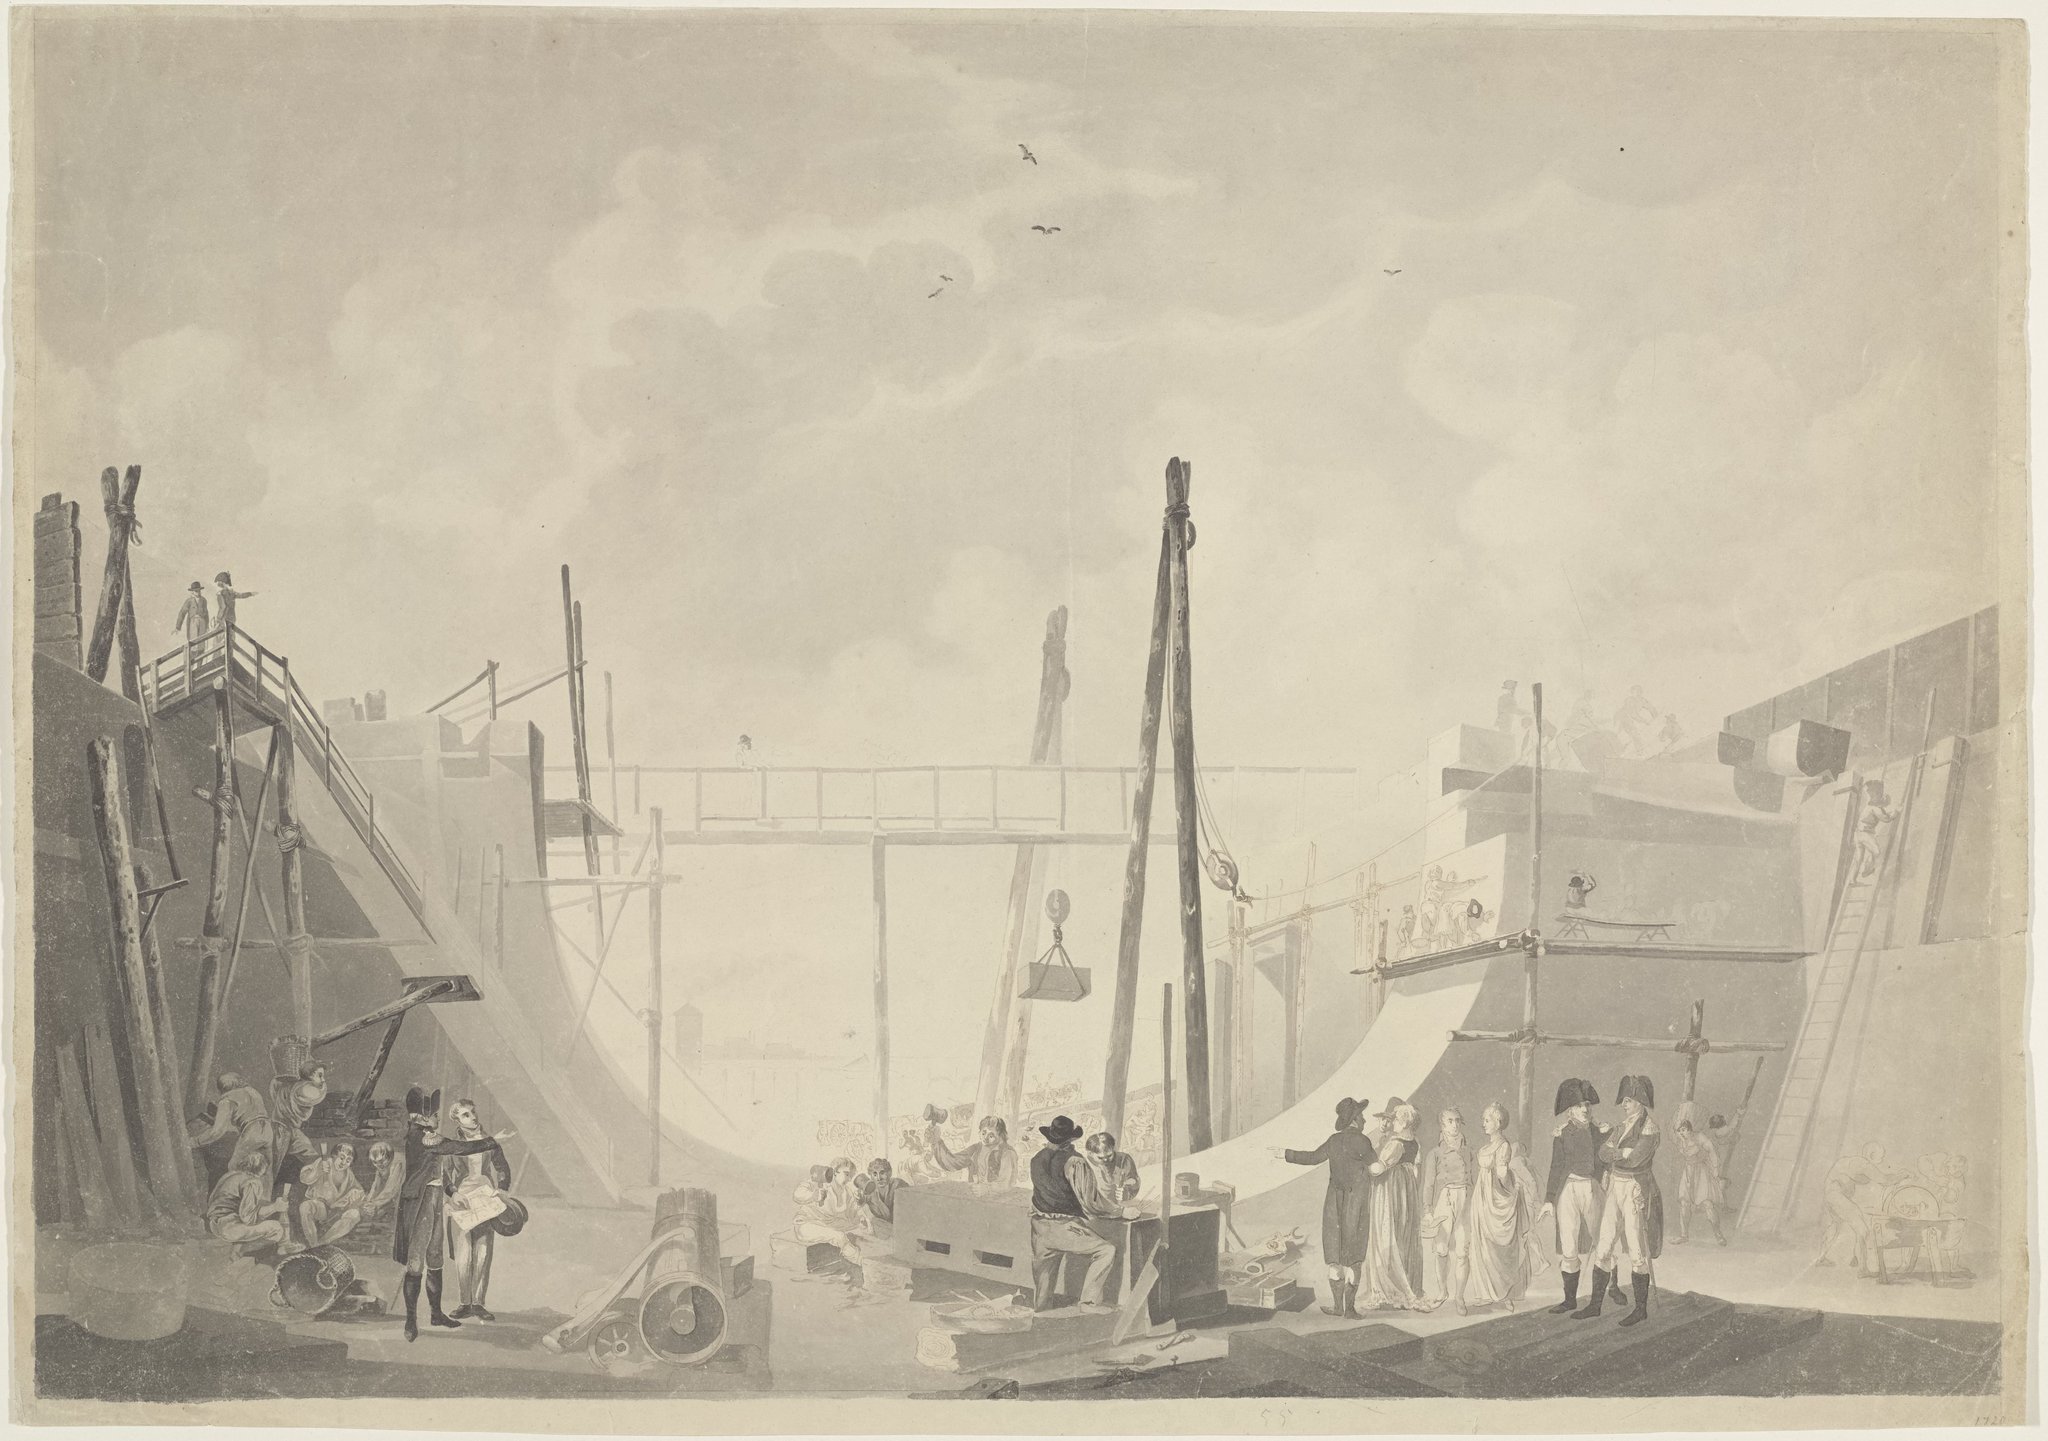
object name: drawing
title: Werkzaamheden aan de zeesluis en droogdok te Hellevoetsluis, ca. 1802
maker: balthazar jooss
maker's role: draughtsman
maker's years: 1772-1834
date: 1802-1806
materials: paper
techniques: brush, pen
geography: netherlands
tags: jan blanken jansz., sluice, weir, dry-dock, floating-dock, hellevoetsluis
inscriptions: collector's mark: Lugt 2228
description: De bouw van de grote schutsluis in het Kanaal door Voorne (Voornsche kanaal) bij Hellevoetsluis, onder toezicht van de waterbouwkundige Jan Blanken, 1803. Gezicht in de bouwput waar arbeiders aan het werk zijn, op de voorgrond rechts enkele bezoekers. Het kanaal werd pas op 30 november 1830 geopend.